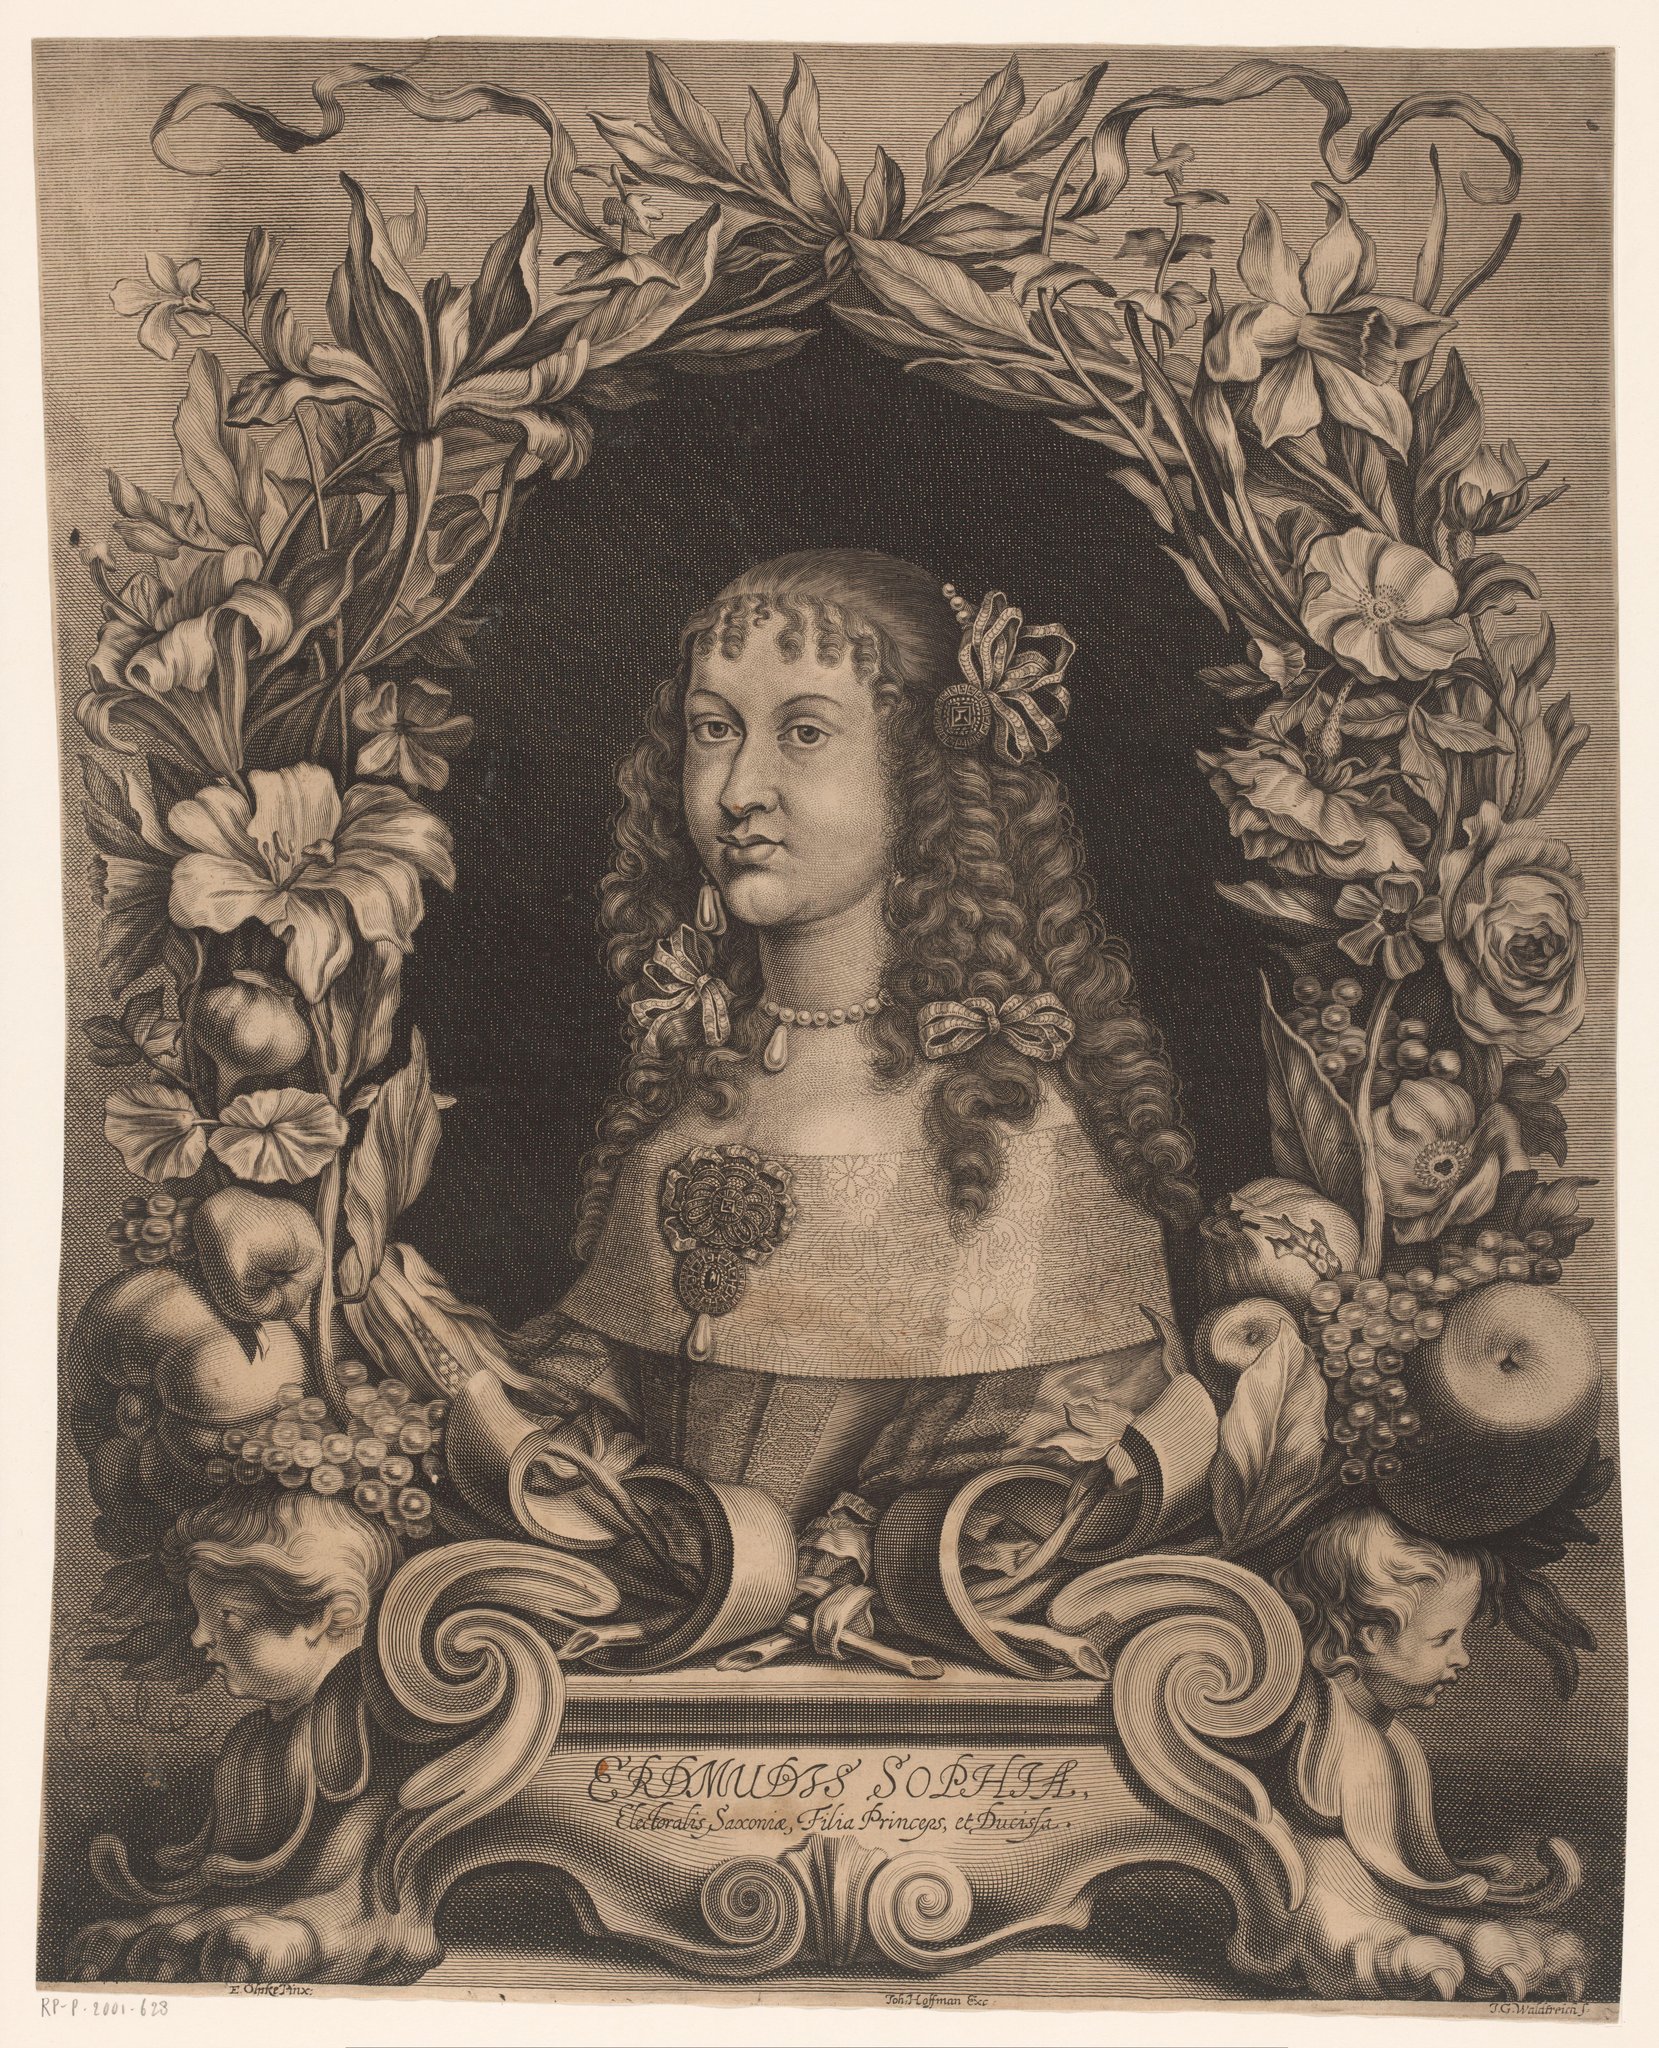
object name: print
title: Rustende herder met vee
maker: francesco londonio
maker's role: print maker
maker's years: 1723-1783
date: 1763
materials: paper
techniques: etching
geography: rome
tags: cow, herding, herdsman, herdswoman, shepherd, shepherdess, cowherd, etc., goat, herd, flock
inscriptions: date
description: Een herder met een staf, zittend op een steen, naast een liggende koe. Achter hen een jongen. Links vier rustende geiten. Op de achtergrond een ruïne.